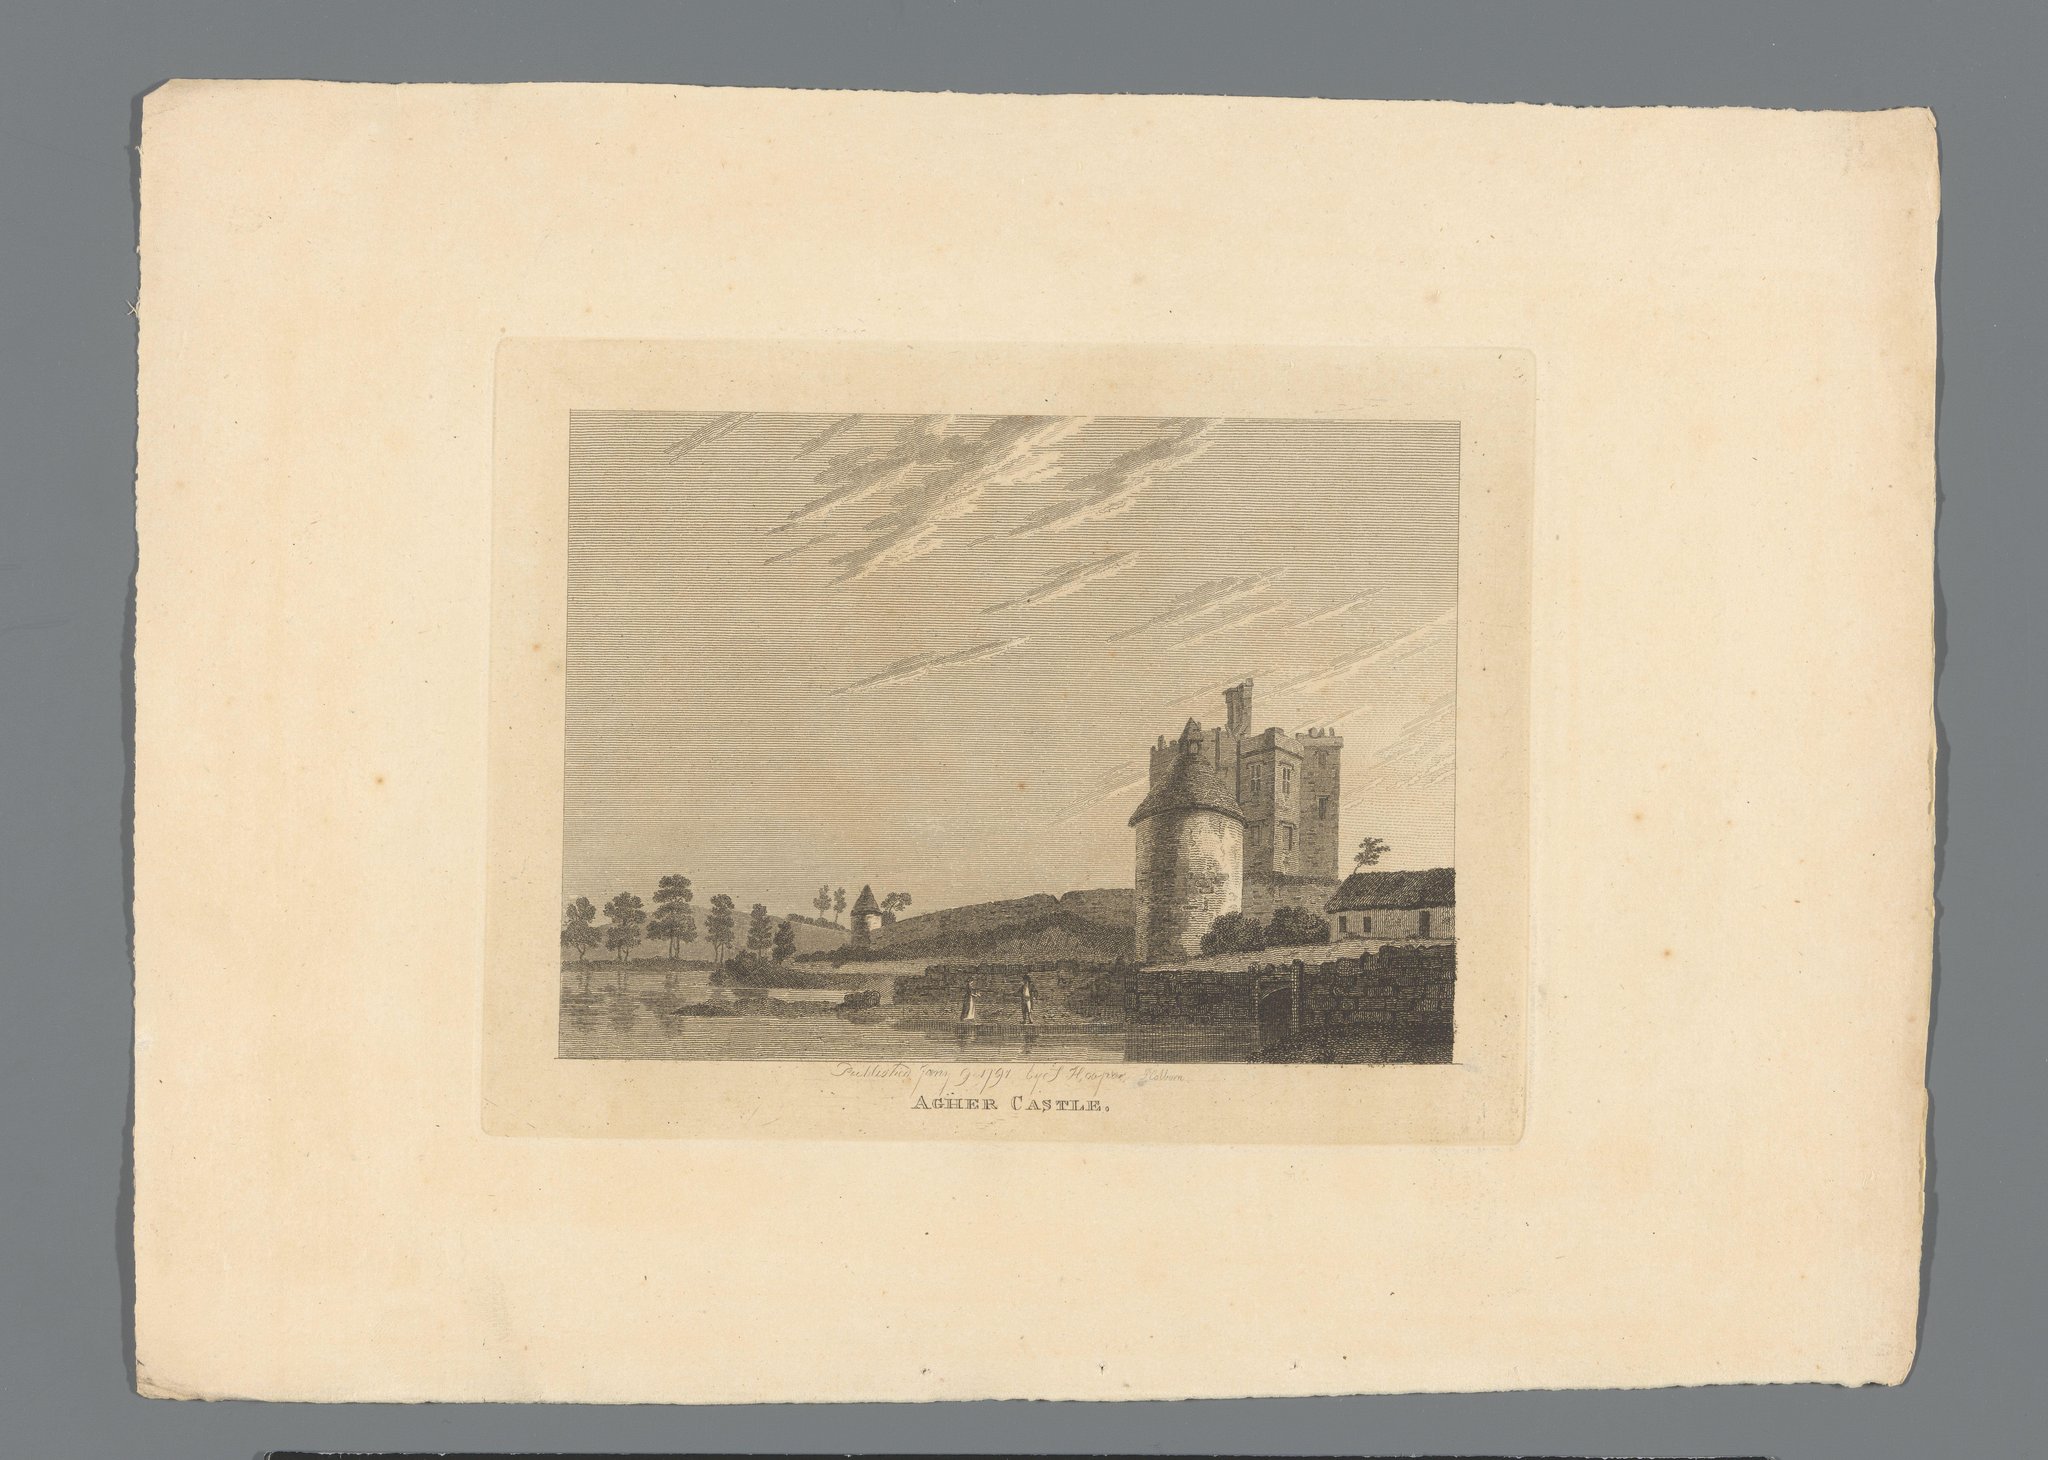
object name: print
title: Agher Castle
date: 1791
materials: paper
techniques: etching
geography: london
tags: landscape with ruins, landscape with tower or castle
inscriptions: date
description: Prent verschenen in: Grose, Francis. The antiquities of Ireland. Londen: S. Hooper, 1795, dl. 2.